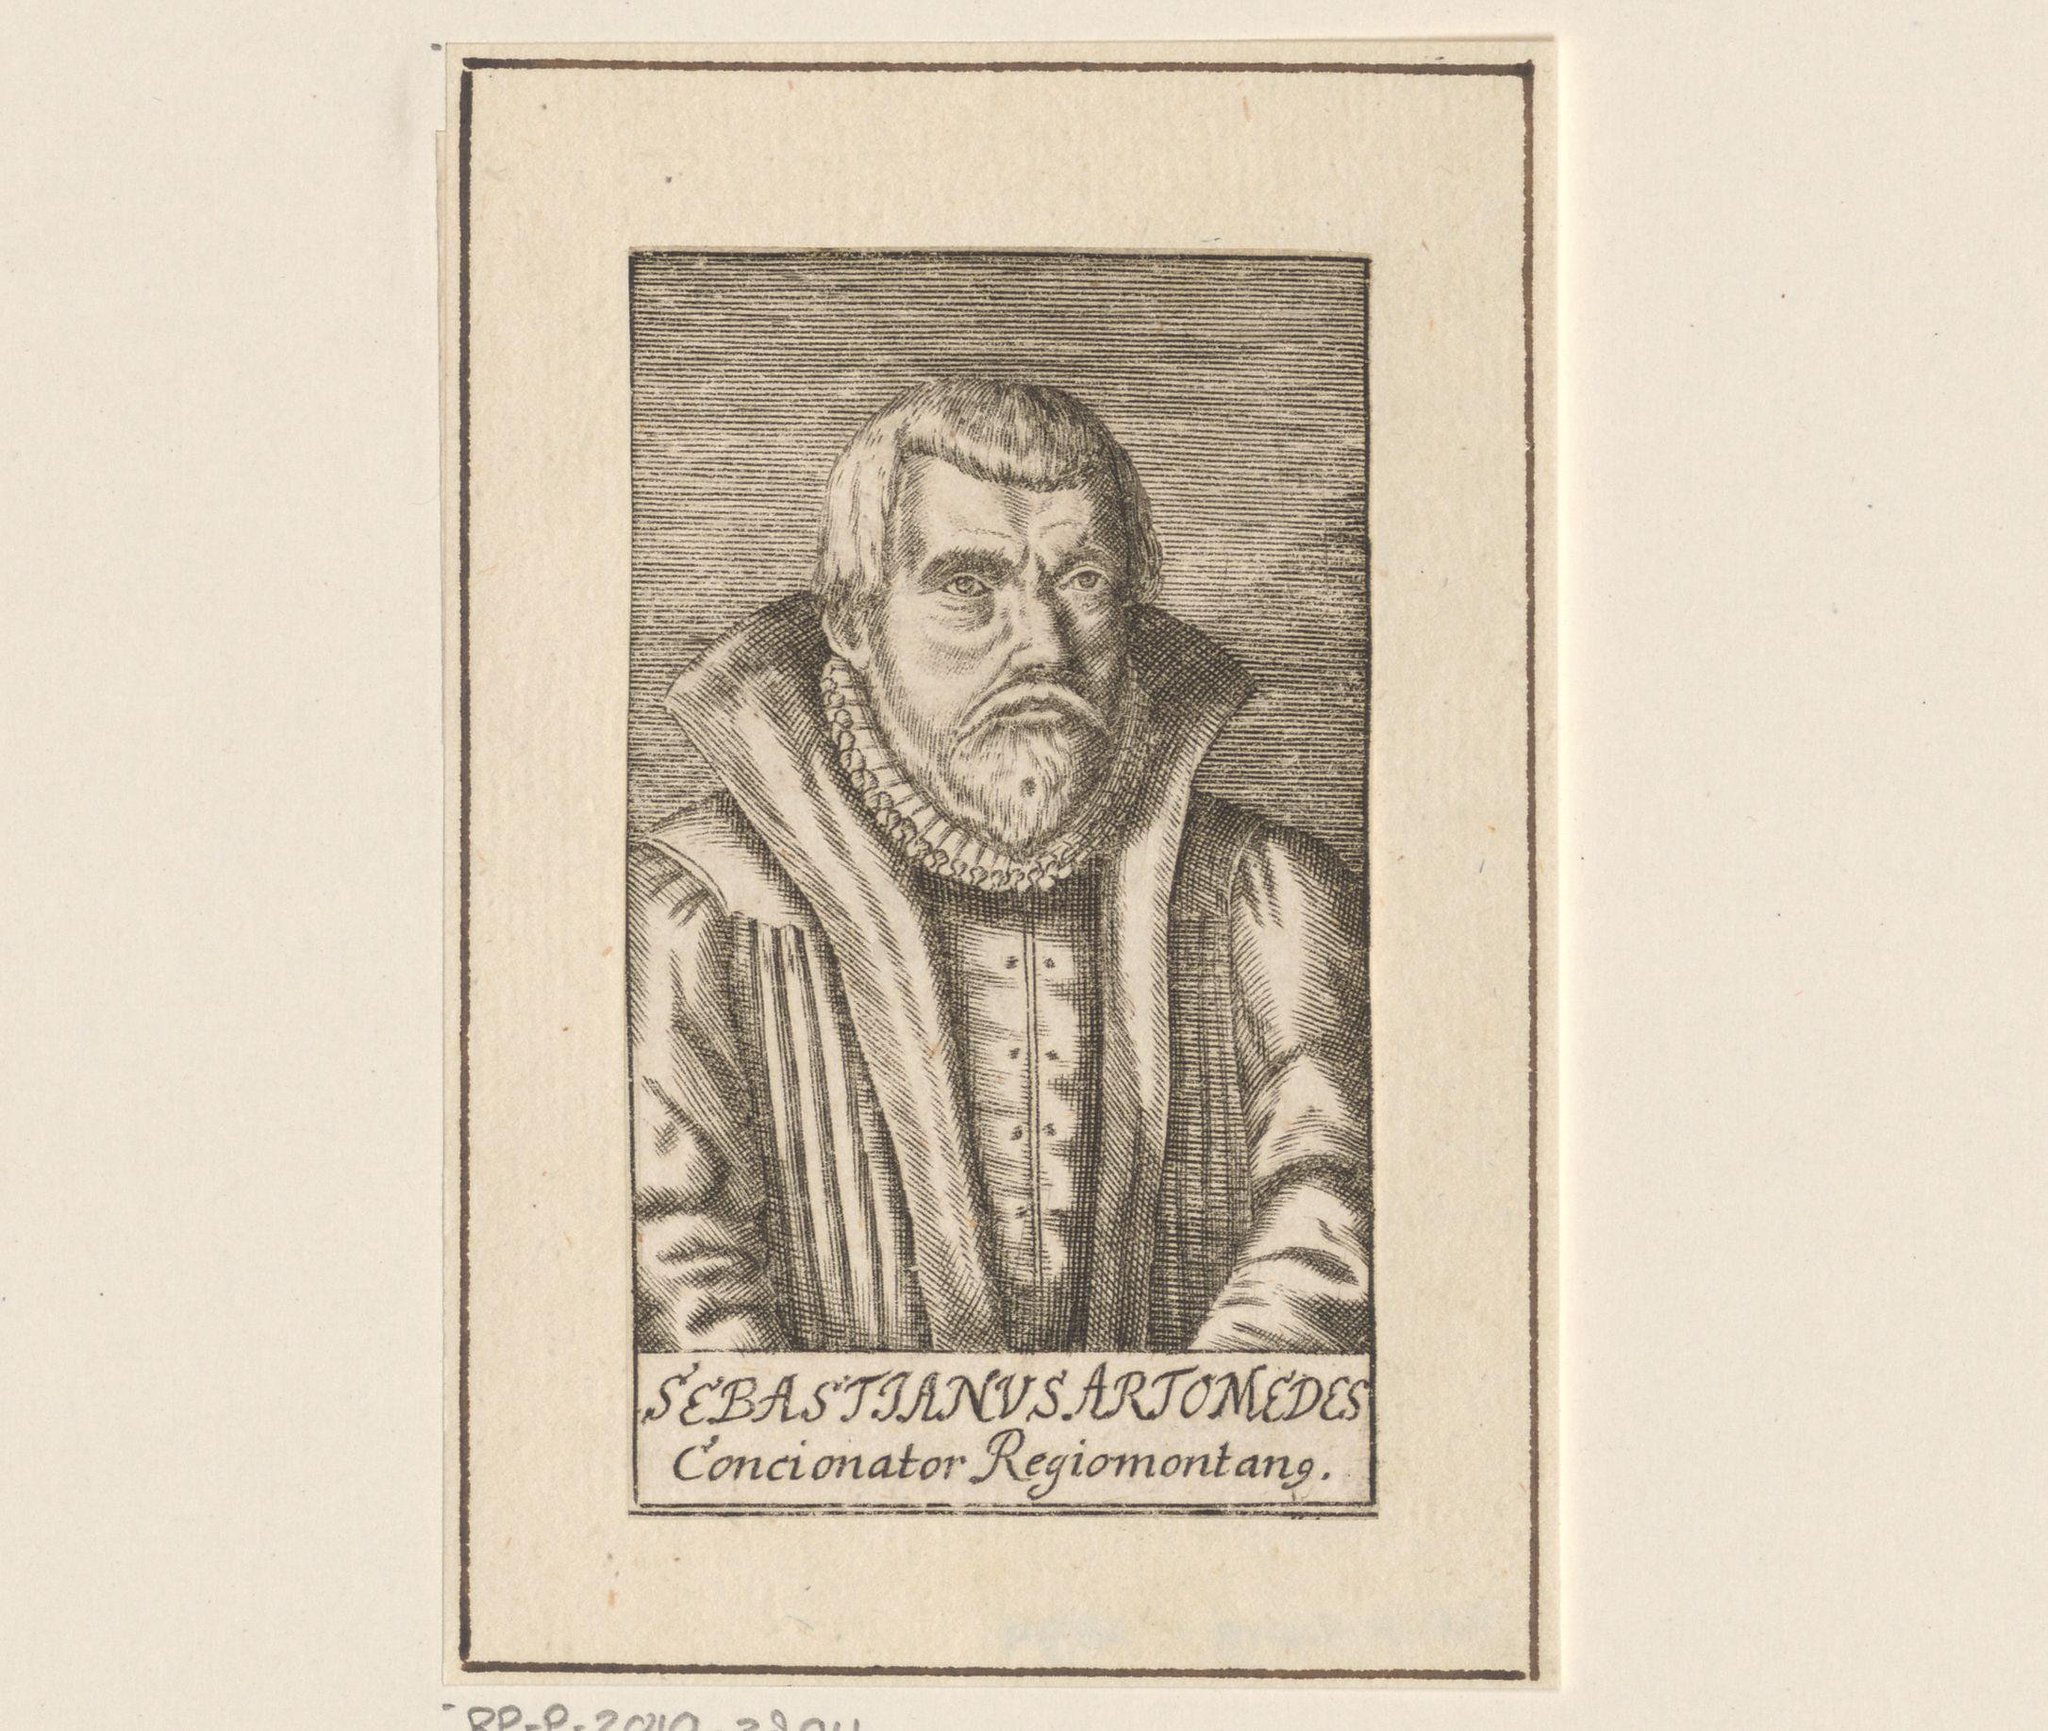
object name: book illustration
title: Portret van Sebastian Artomedes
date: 1688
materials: paper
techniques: engraving, etching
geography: nuremberg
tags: theologian, historical persons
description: Prent uit: Freher, Paul. Theatrum virorum eruditione clarorum. Neurenberg: Johann Hoffmann, 1688.